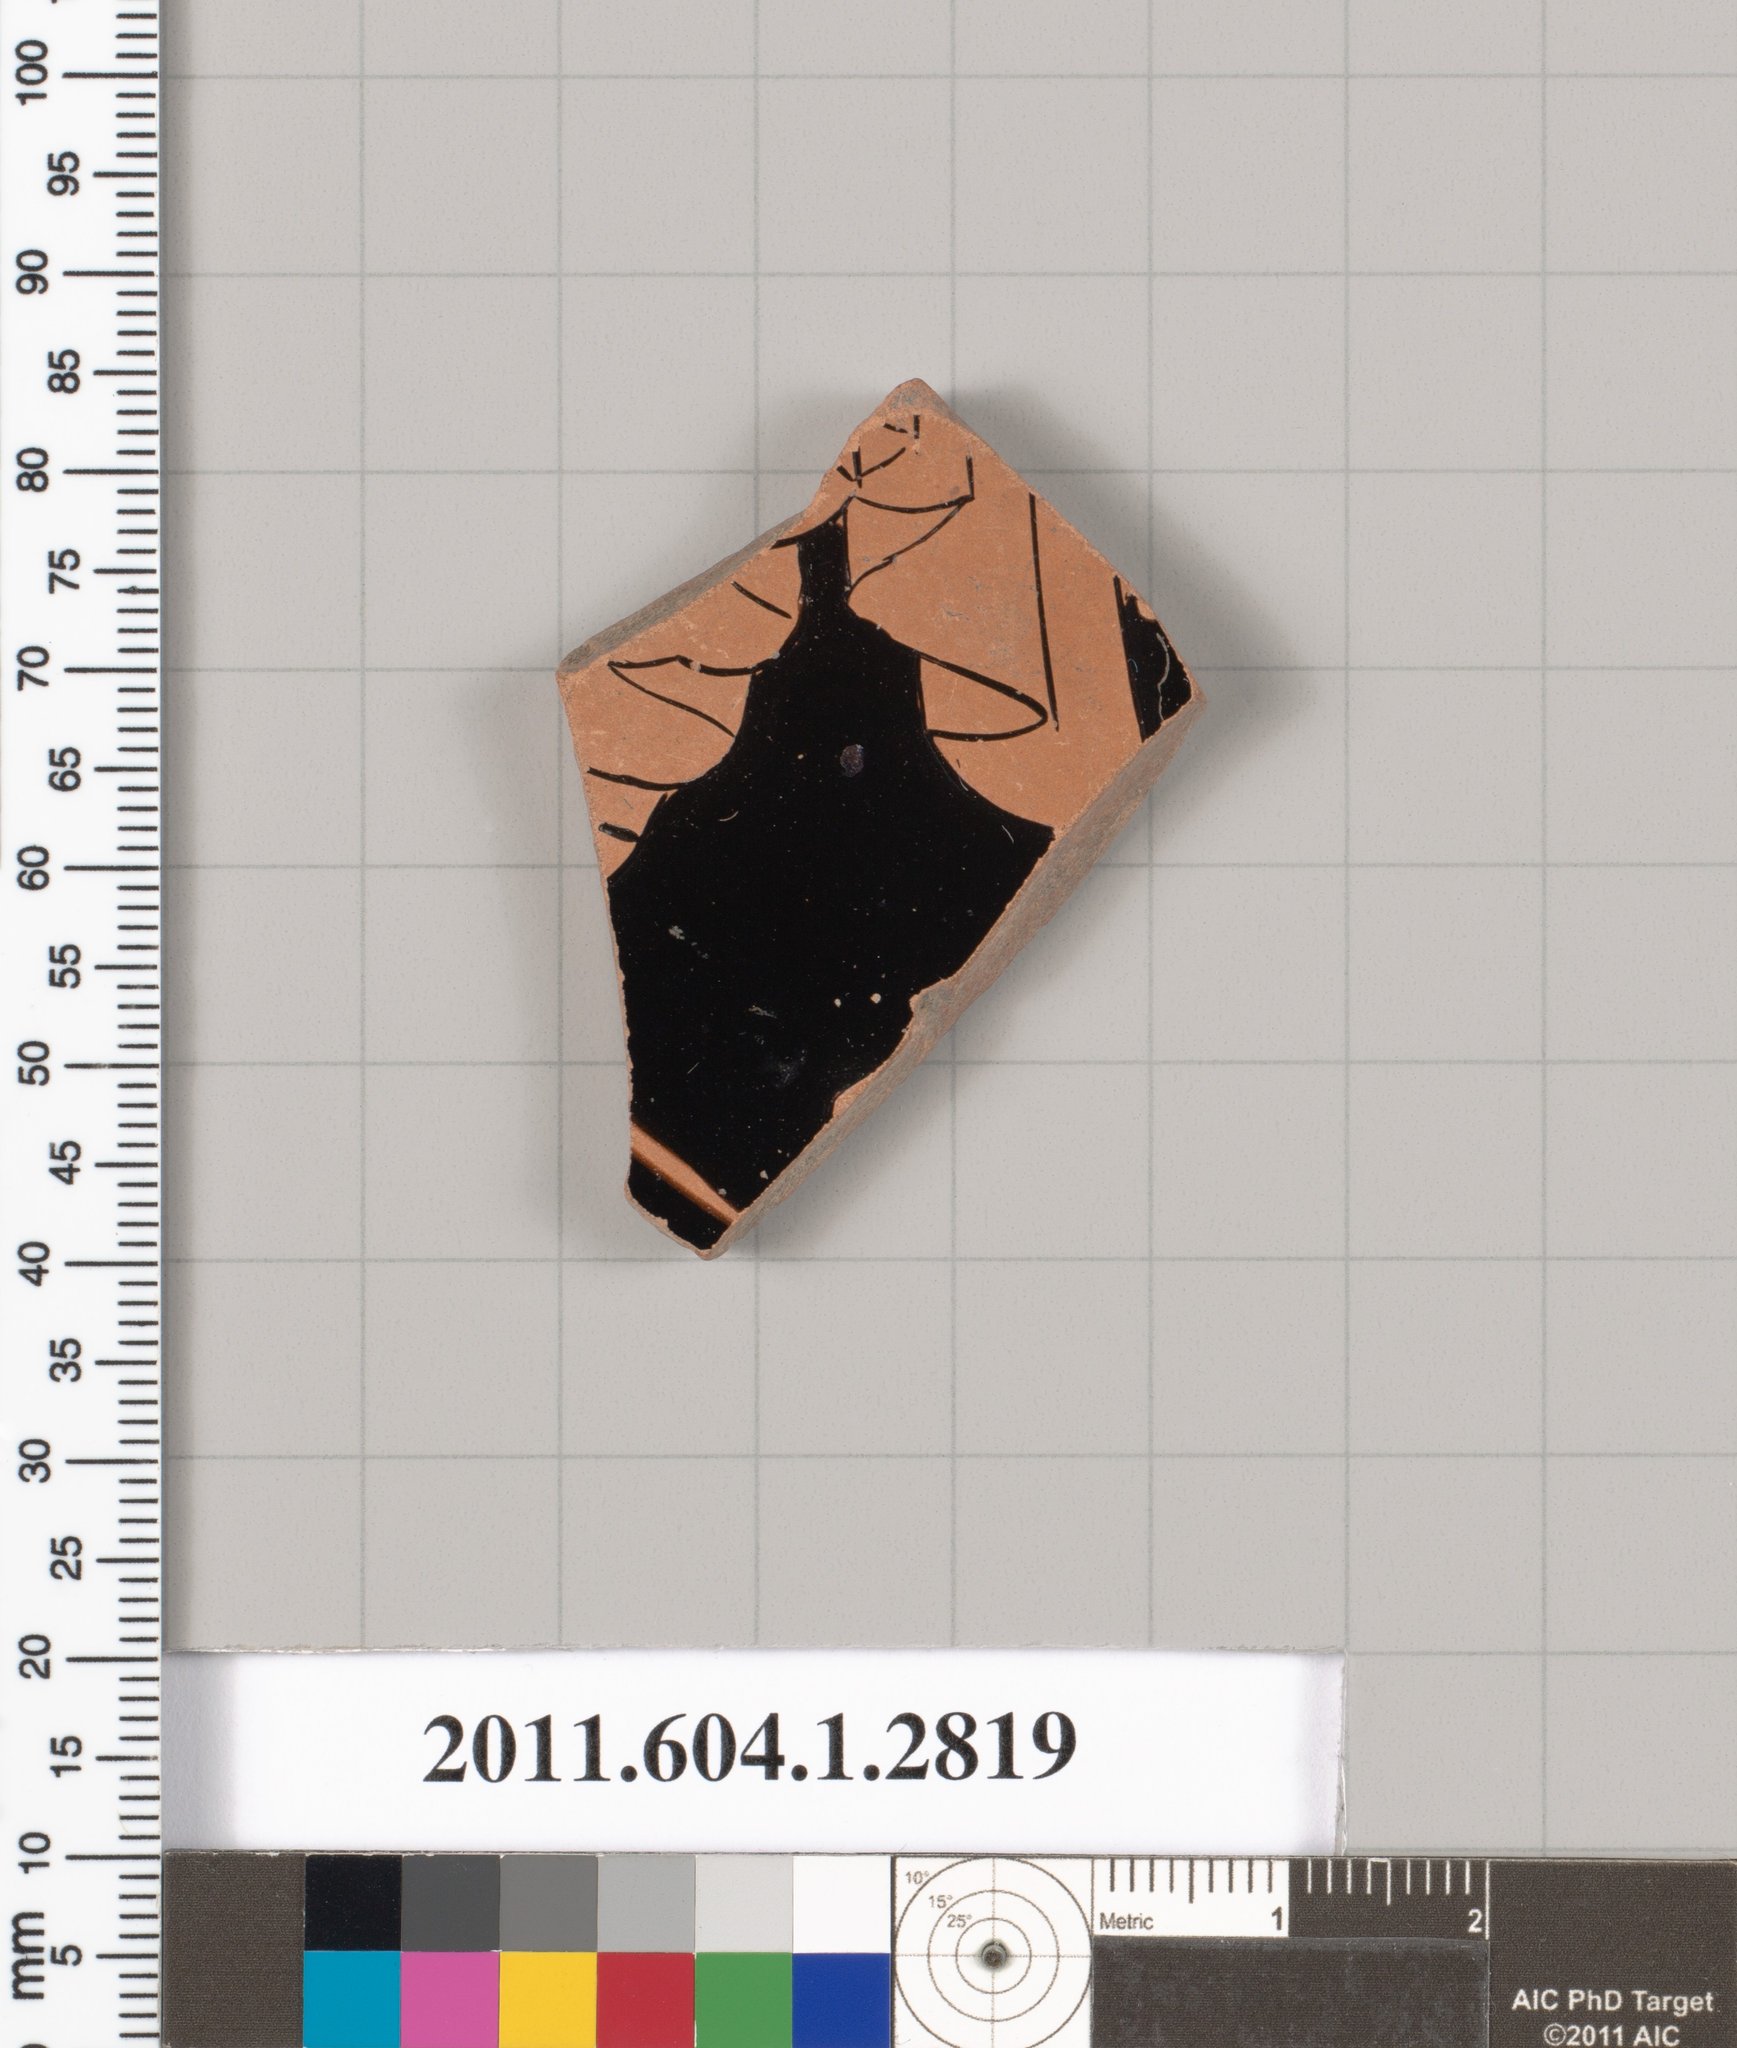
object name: kylix fragment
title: Terracotta fragment of a kylix (drinking cup)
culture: greek, attic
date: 520-500 BCE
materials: terracotta